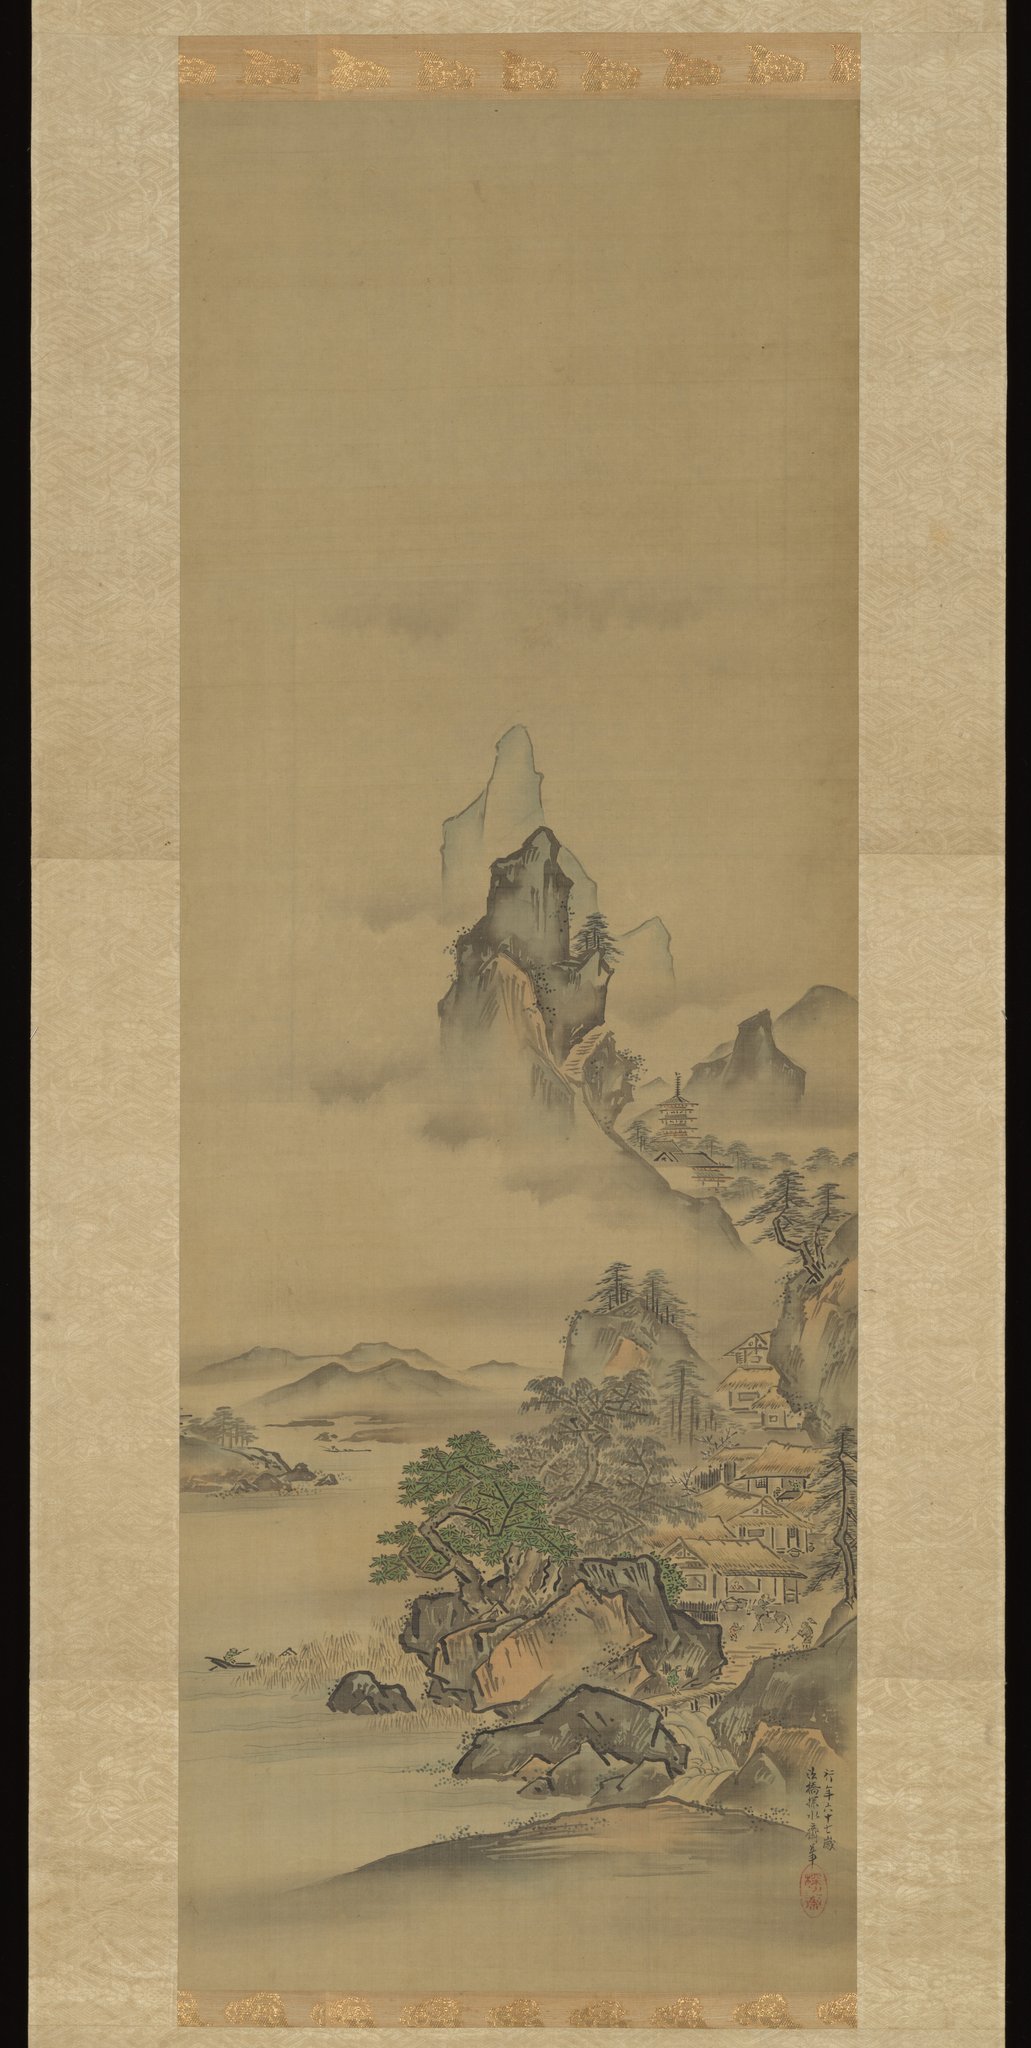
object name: hanging scroll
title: Mount Penglai with Eight Views of Xiao and Xiang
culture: japanese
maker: kano tansui moritsune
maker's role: artist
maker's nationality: japanese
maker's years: 1800-1899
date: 1801-1900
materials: ink, silk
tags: mountains,landscapes